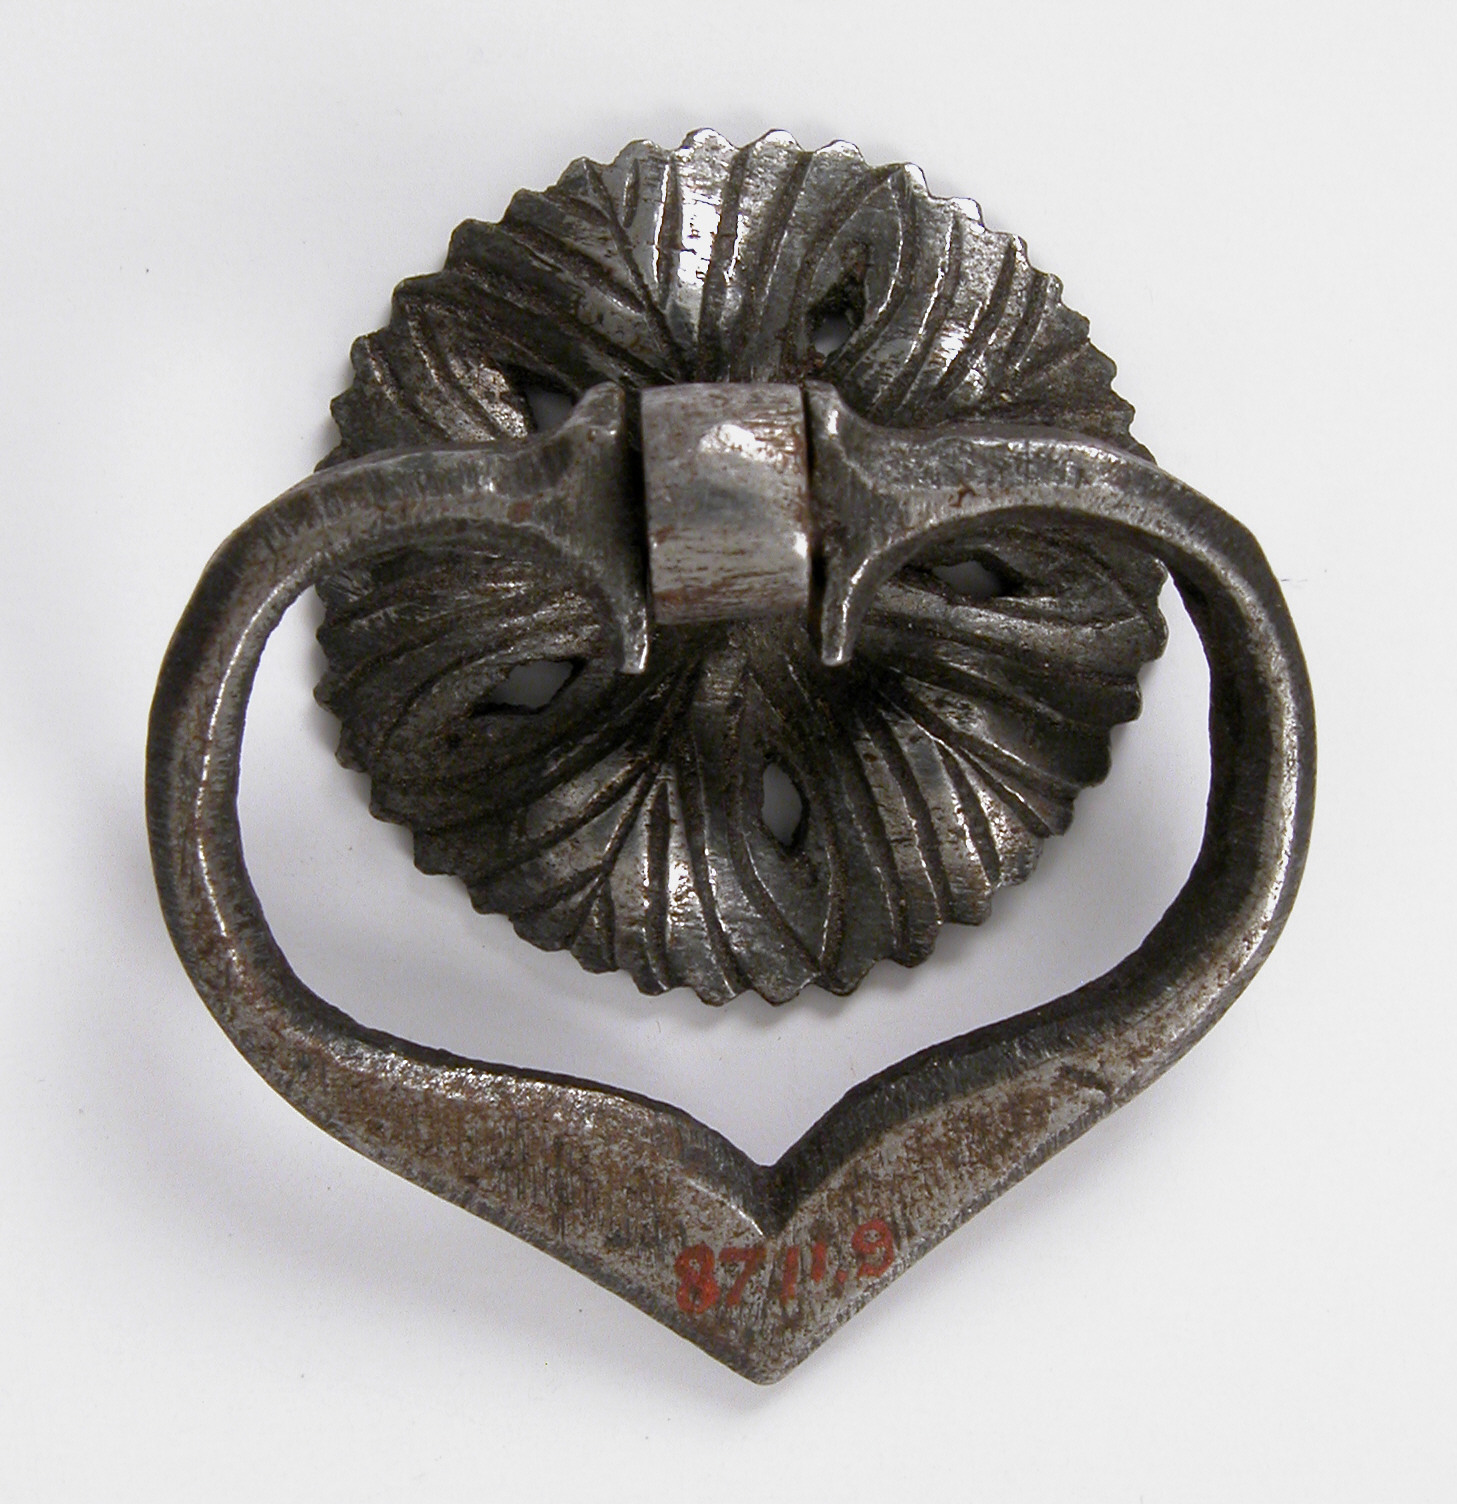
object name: door handle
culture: german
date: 1401-1500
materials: iron